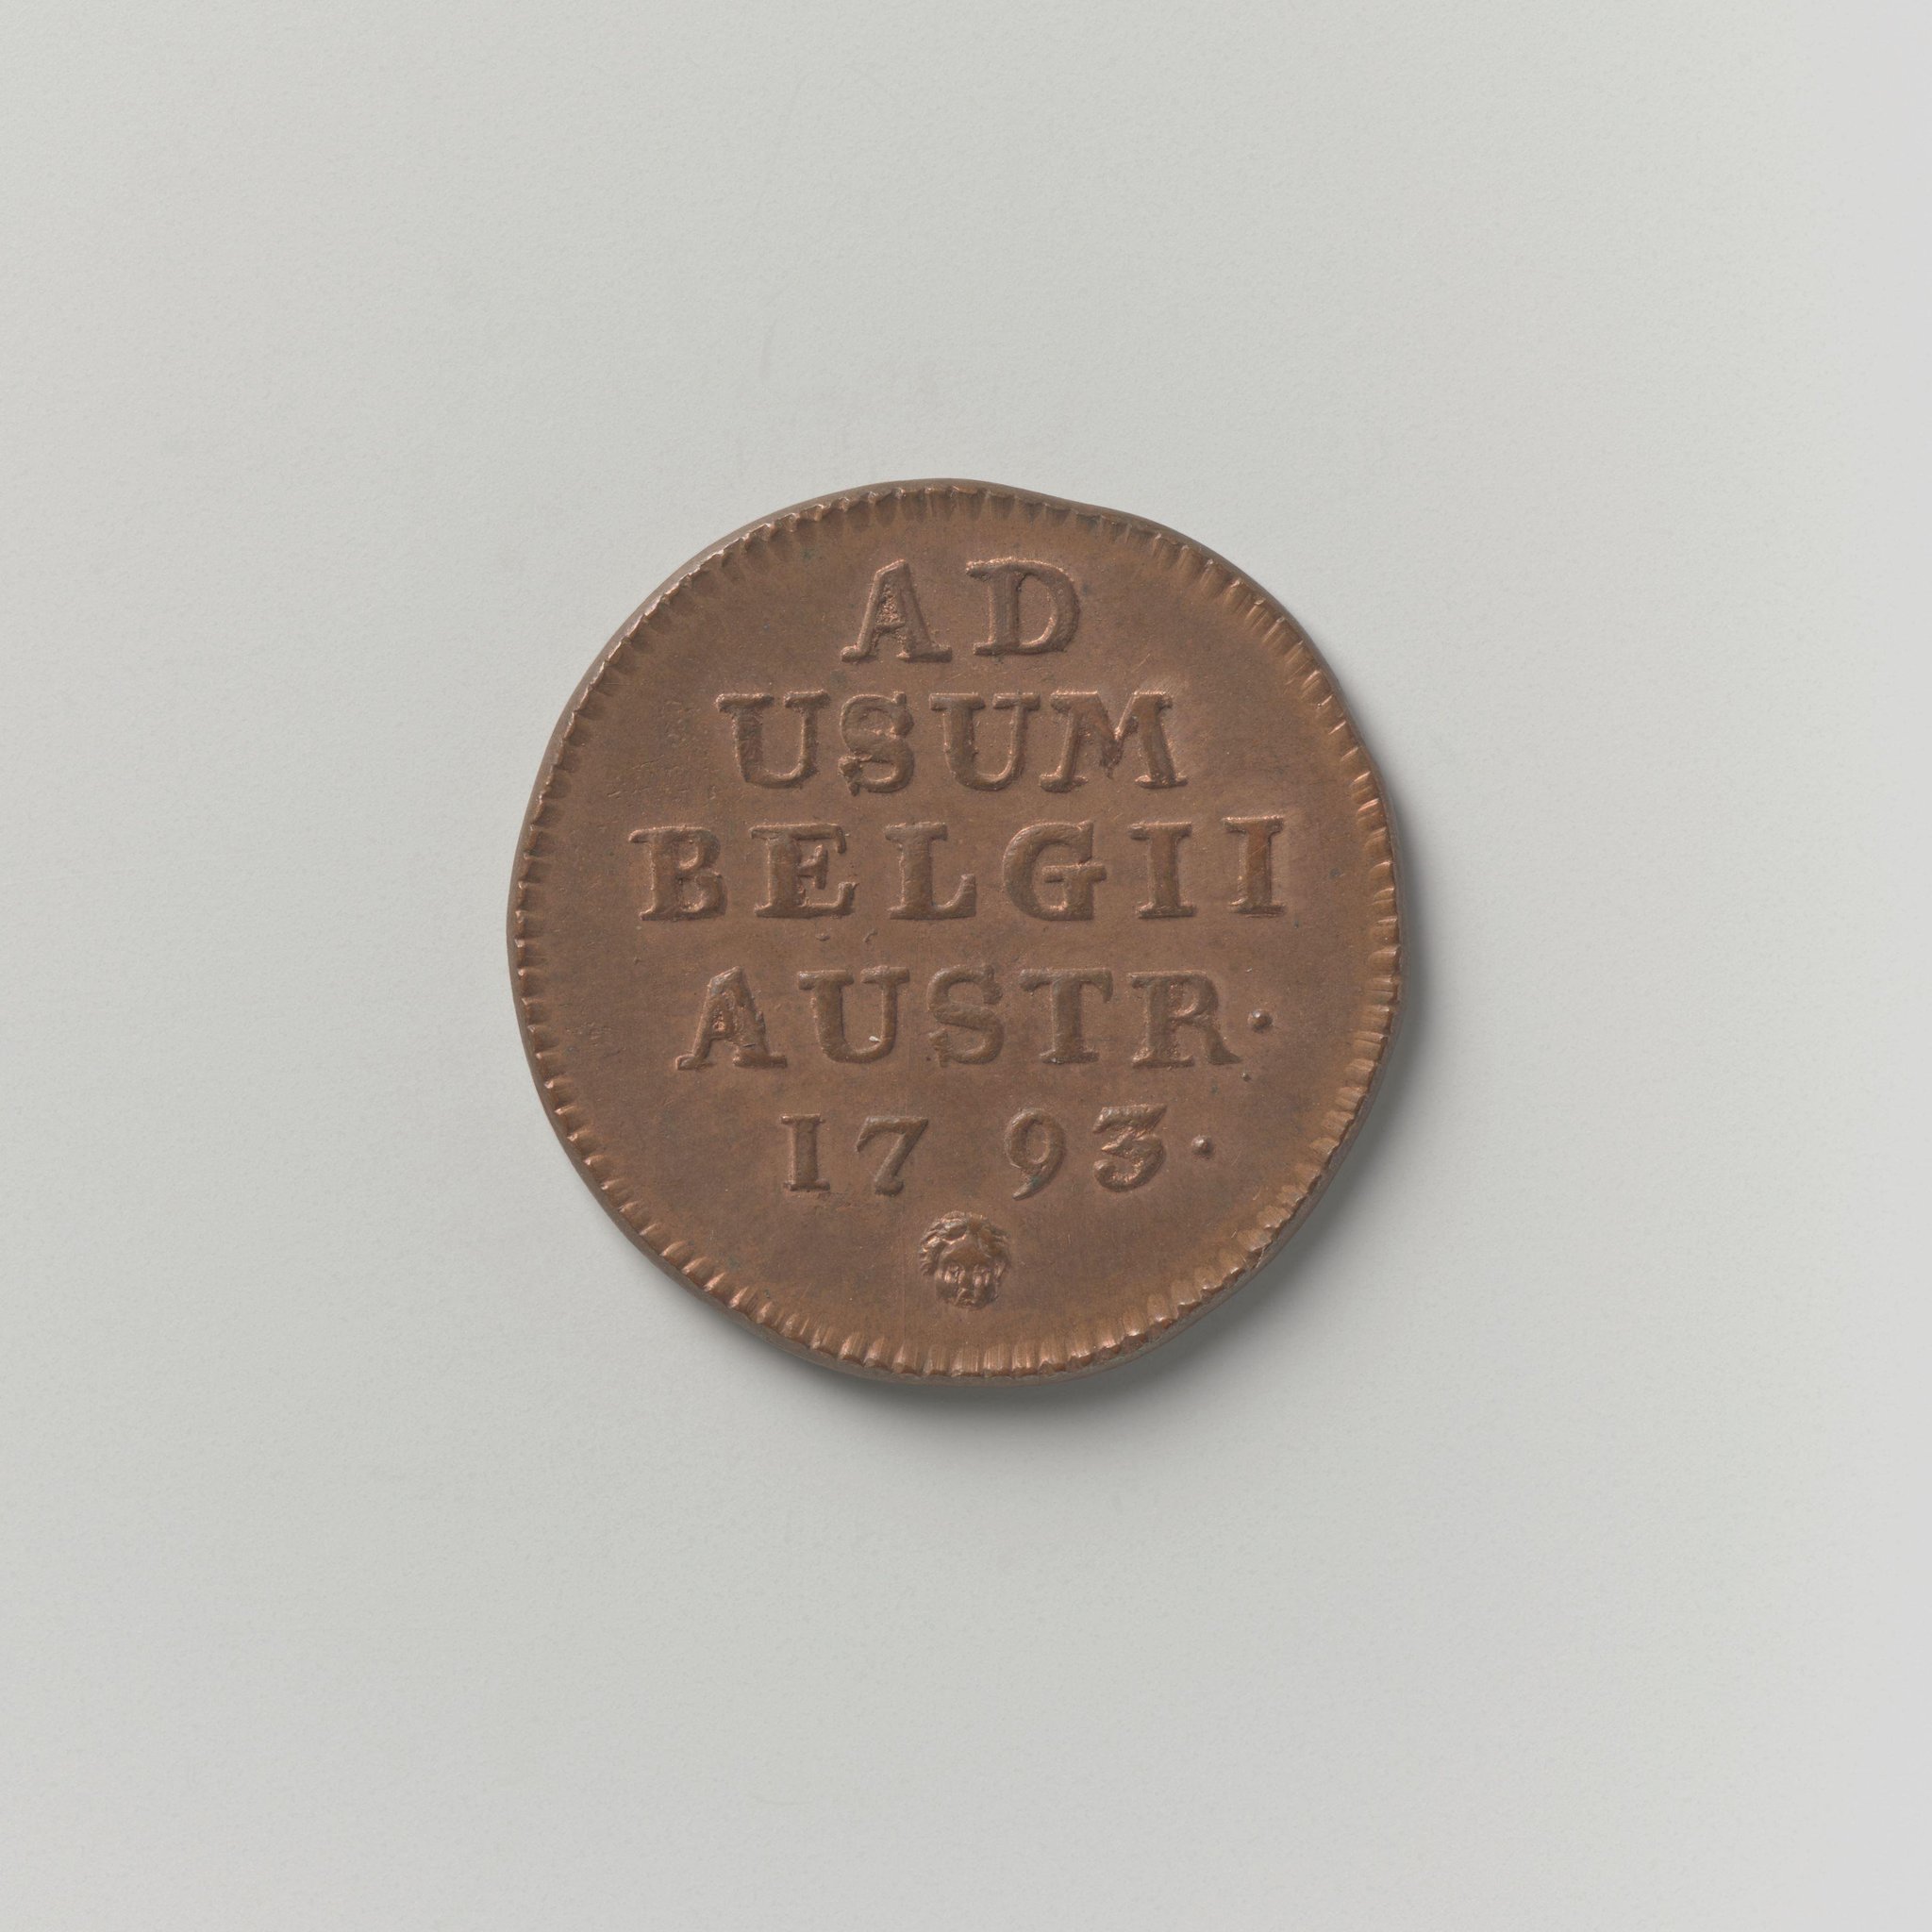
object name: coin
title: Oord uit Brabant van Frans II,1793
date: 1793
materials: copper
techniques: striking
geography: brussels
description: Koperen munt. Voorzijde: portret van Frans II naar rechts. Keerzijde: vierregelig opschrift, waaronder jaartal. Daaronder engelenkop.